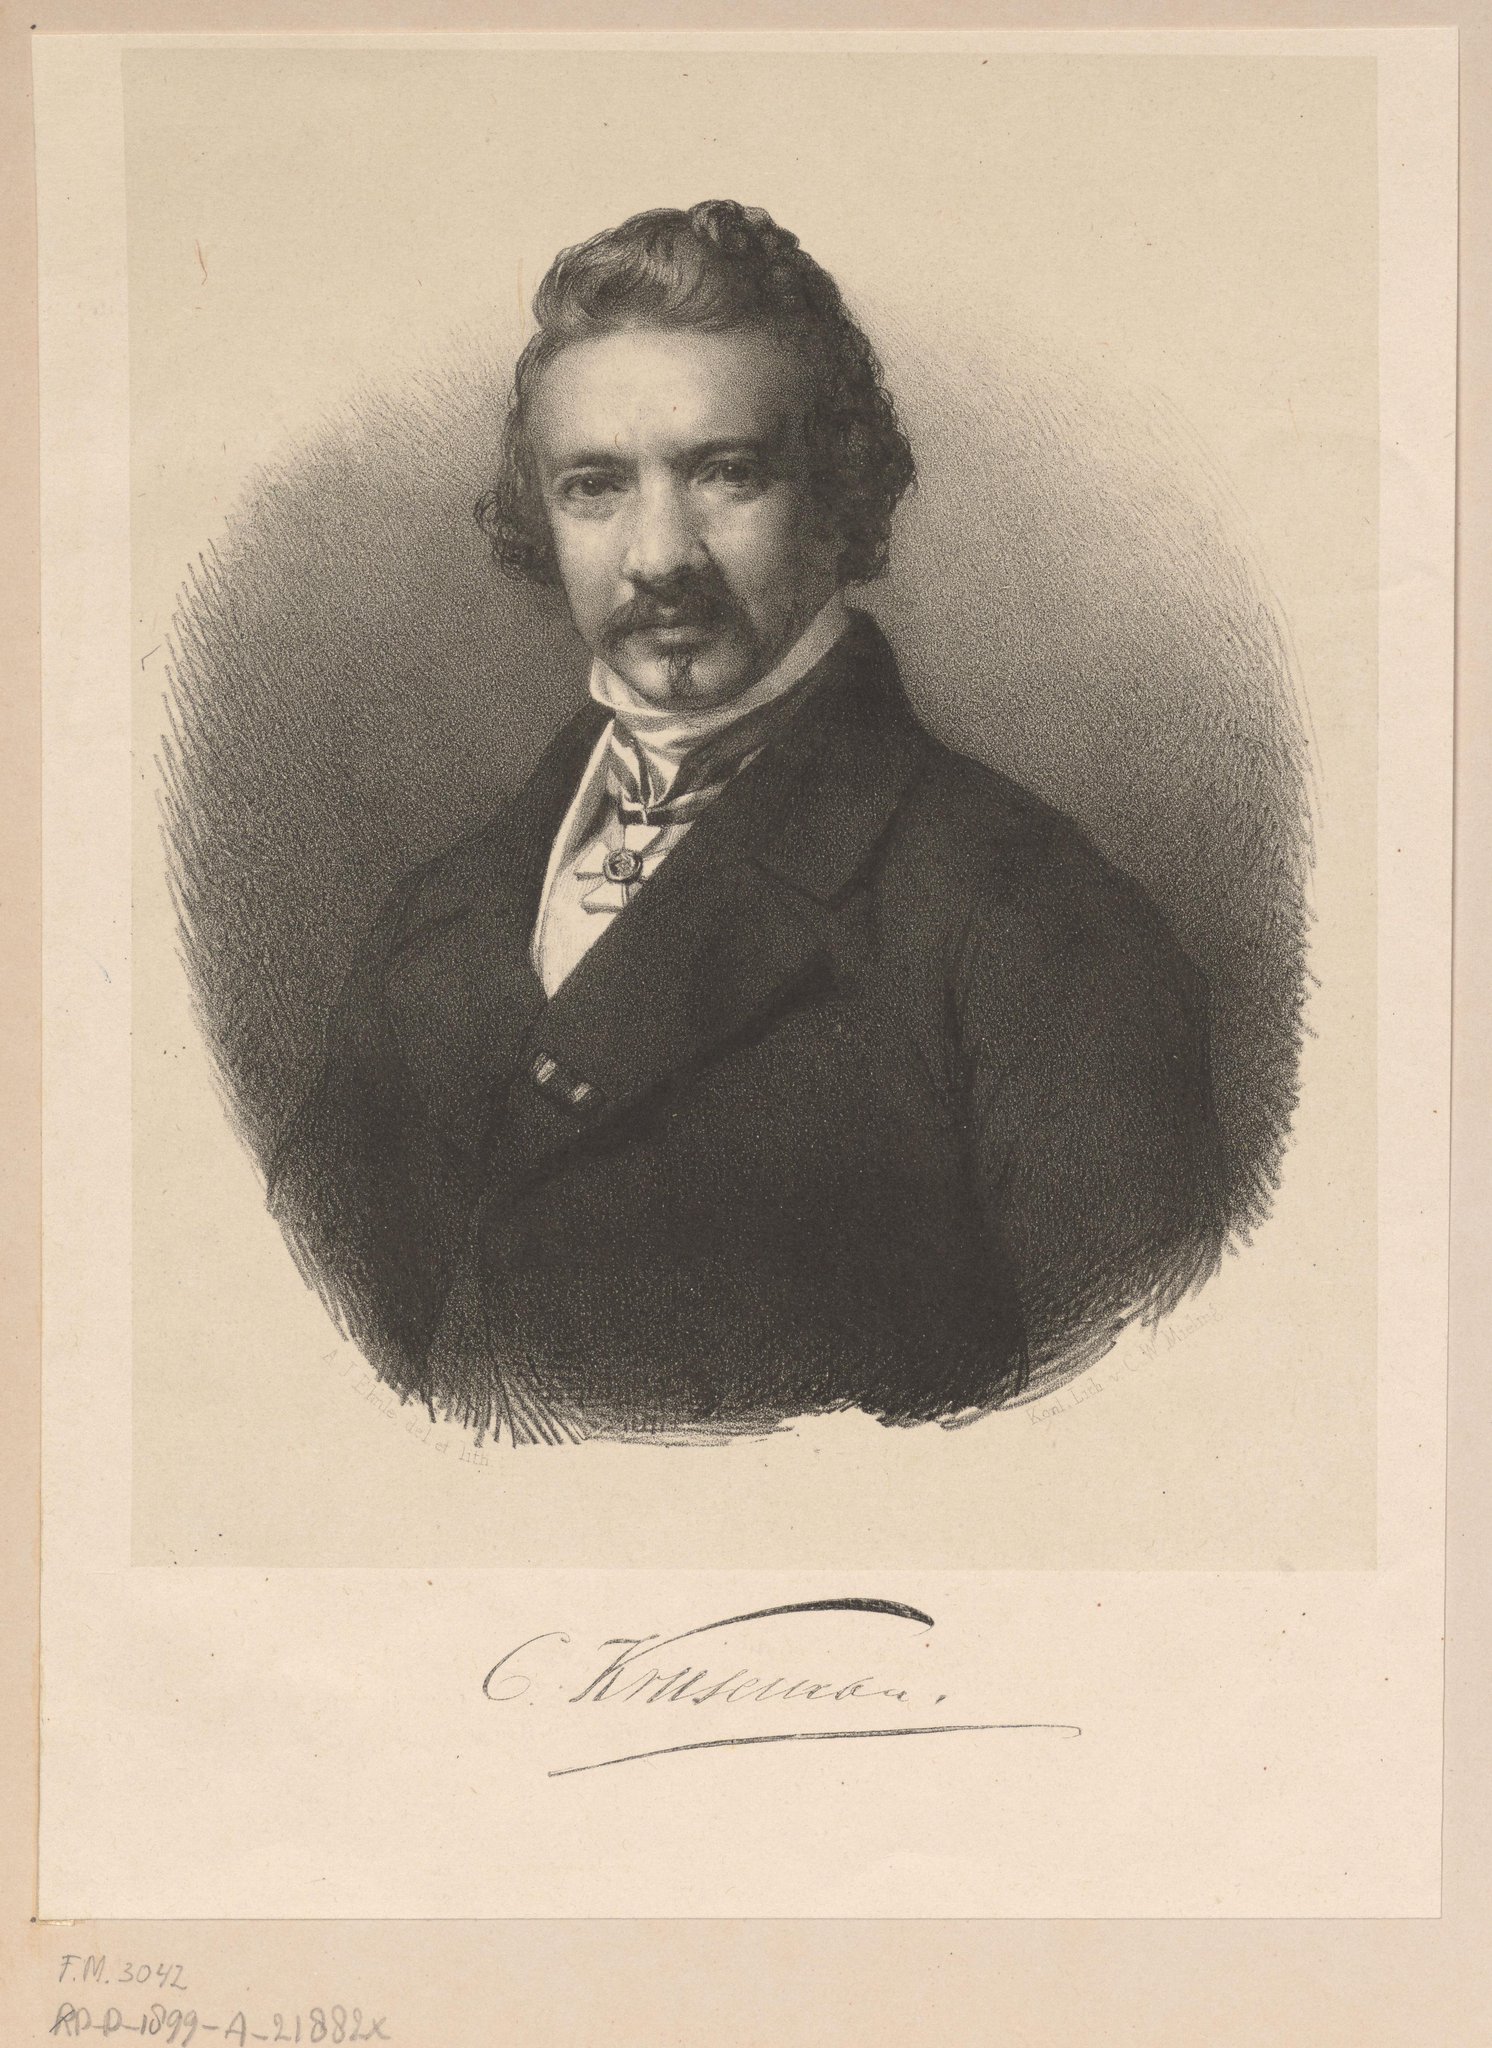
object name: print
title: Portret van Cornelis Kruseman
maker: adrianus johannes ehnle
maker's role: draughtsman, print maker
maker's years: 1819-1863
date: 1829-1853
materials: paper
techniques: lithograph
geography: the hague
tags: painter, cornelis kruseman, historical persons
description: Onder het portret een facsimile van de handtekening van de geportretteerde.